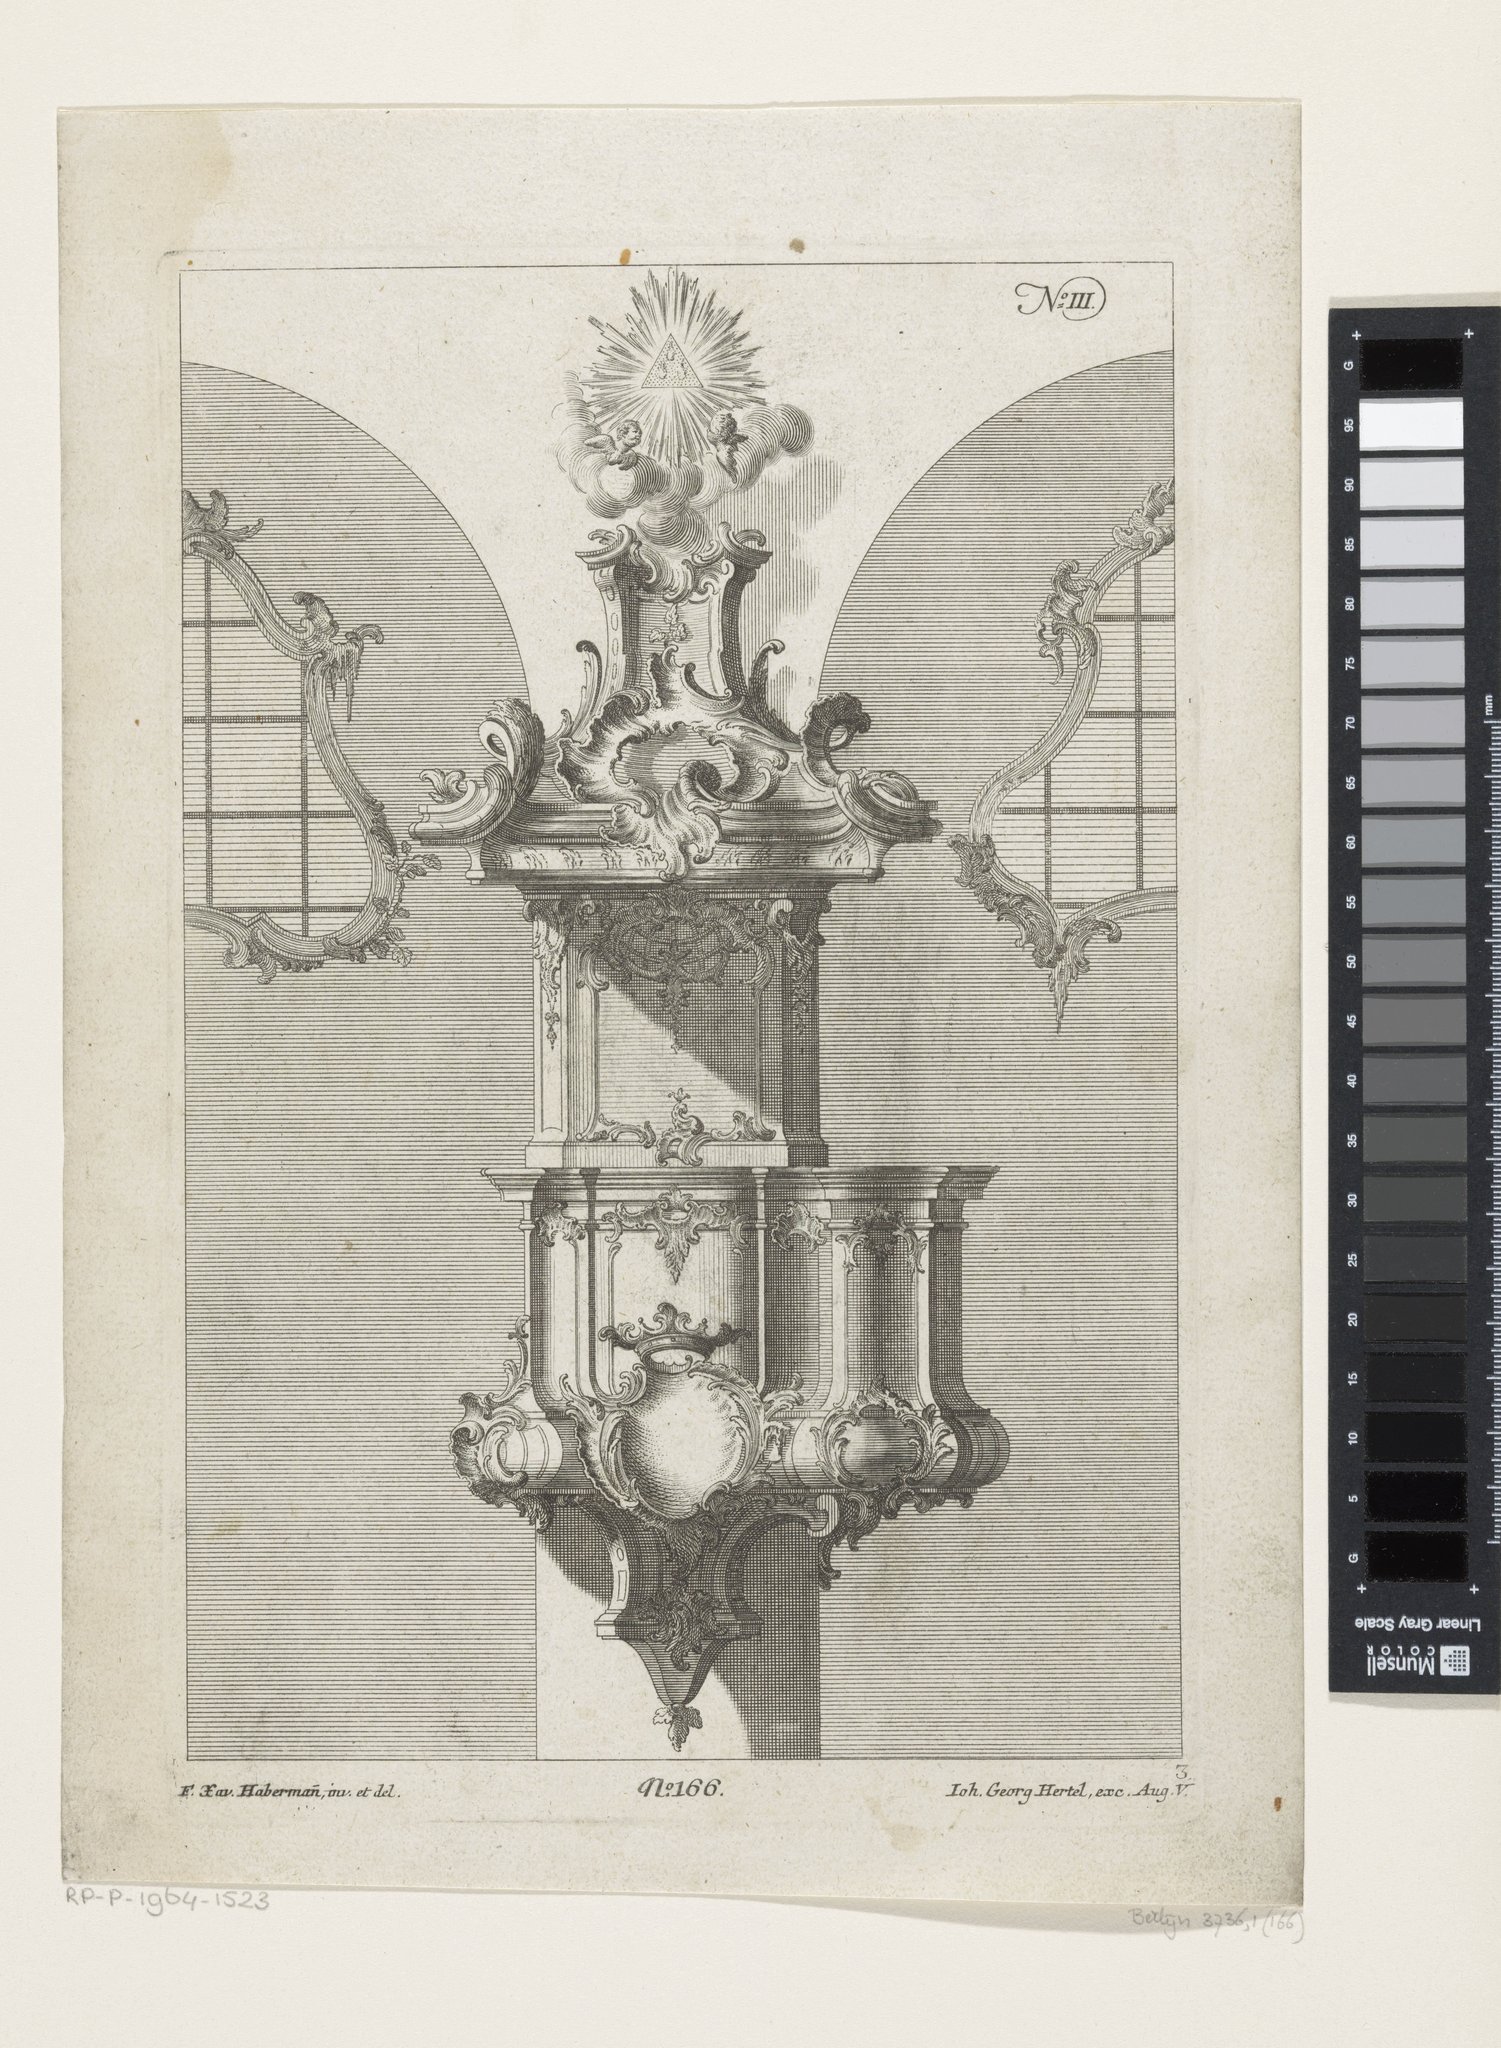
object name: print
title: Preekstoel met symbool drie-eenheid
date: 1740-1745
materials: paper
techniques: engraving, etching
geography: augsburg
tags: rocaille ornament, pulpit, ambo, chancel, symbols of the trinity ~ circular and/or triangular forms or arrangements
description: Preekstoel met rocaille ornamenten tussen twee vensters. Aan bovenzijde gevleugelde putti en driehoek met drie vlammen in stralenkrans. Uitgeversnummer 166.